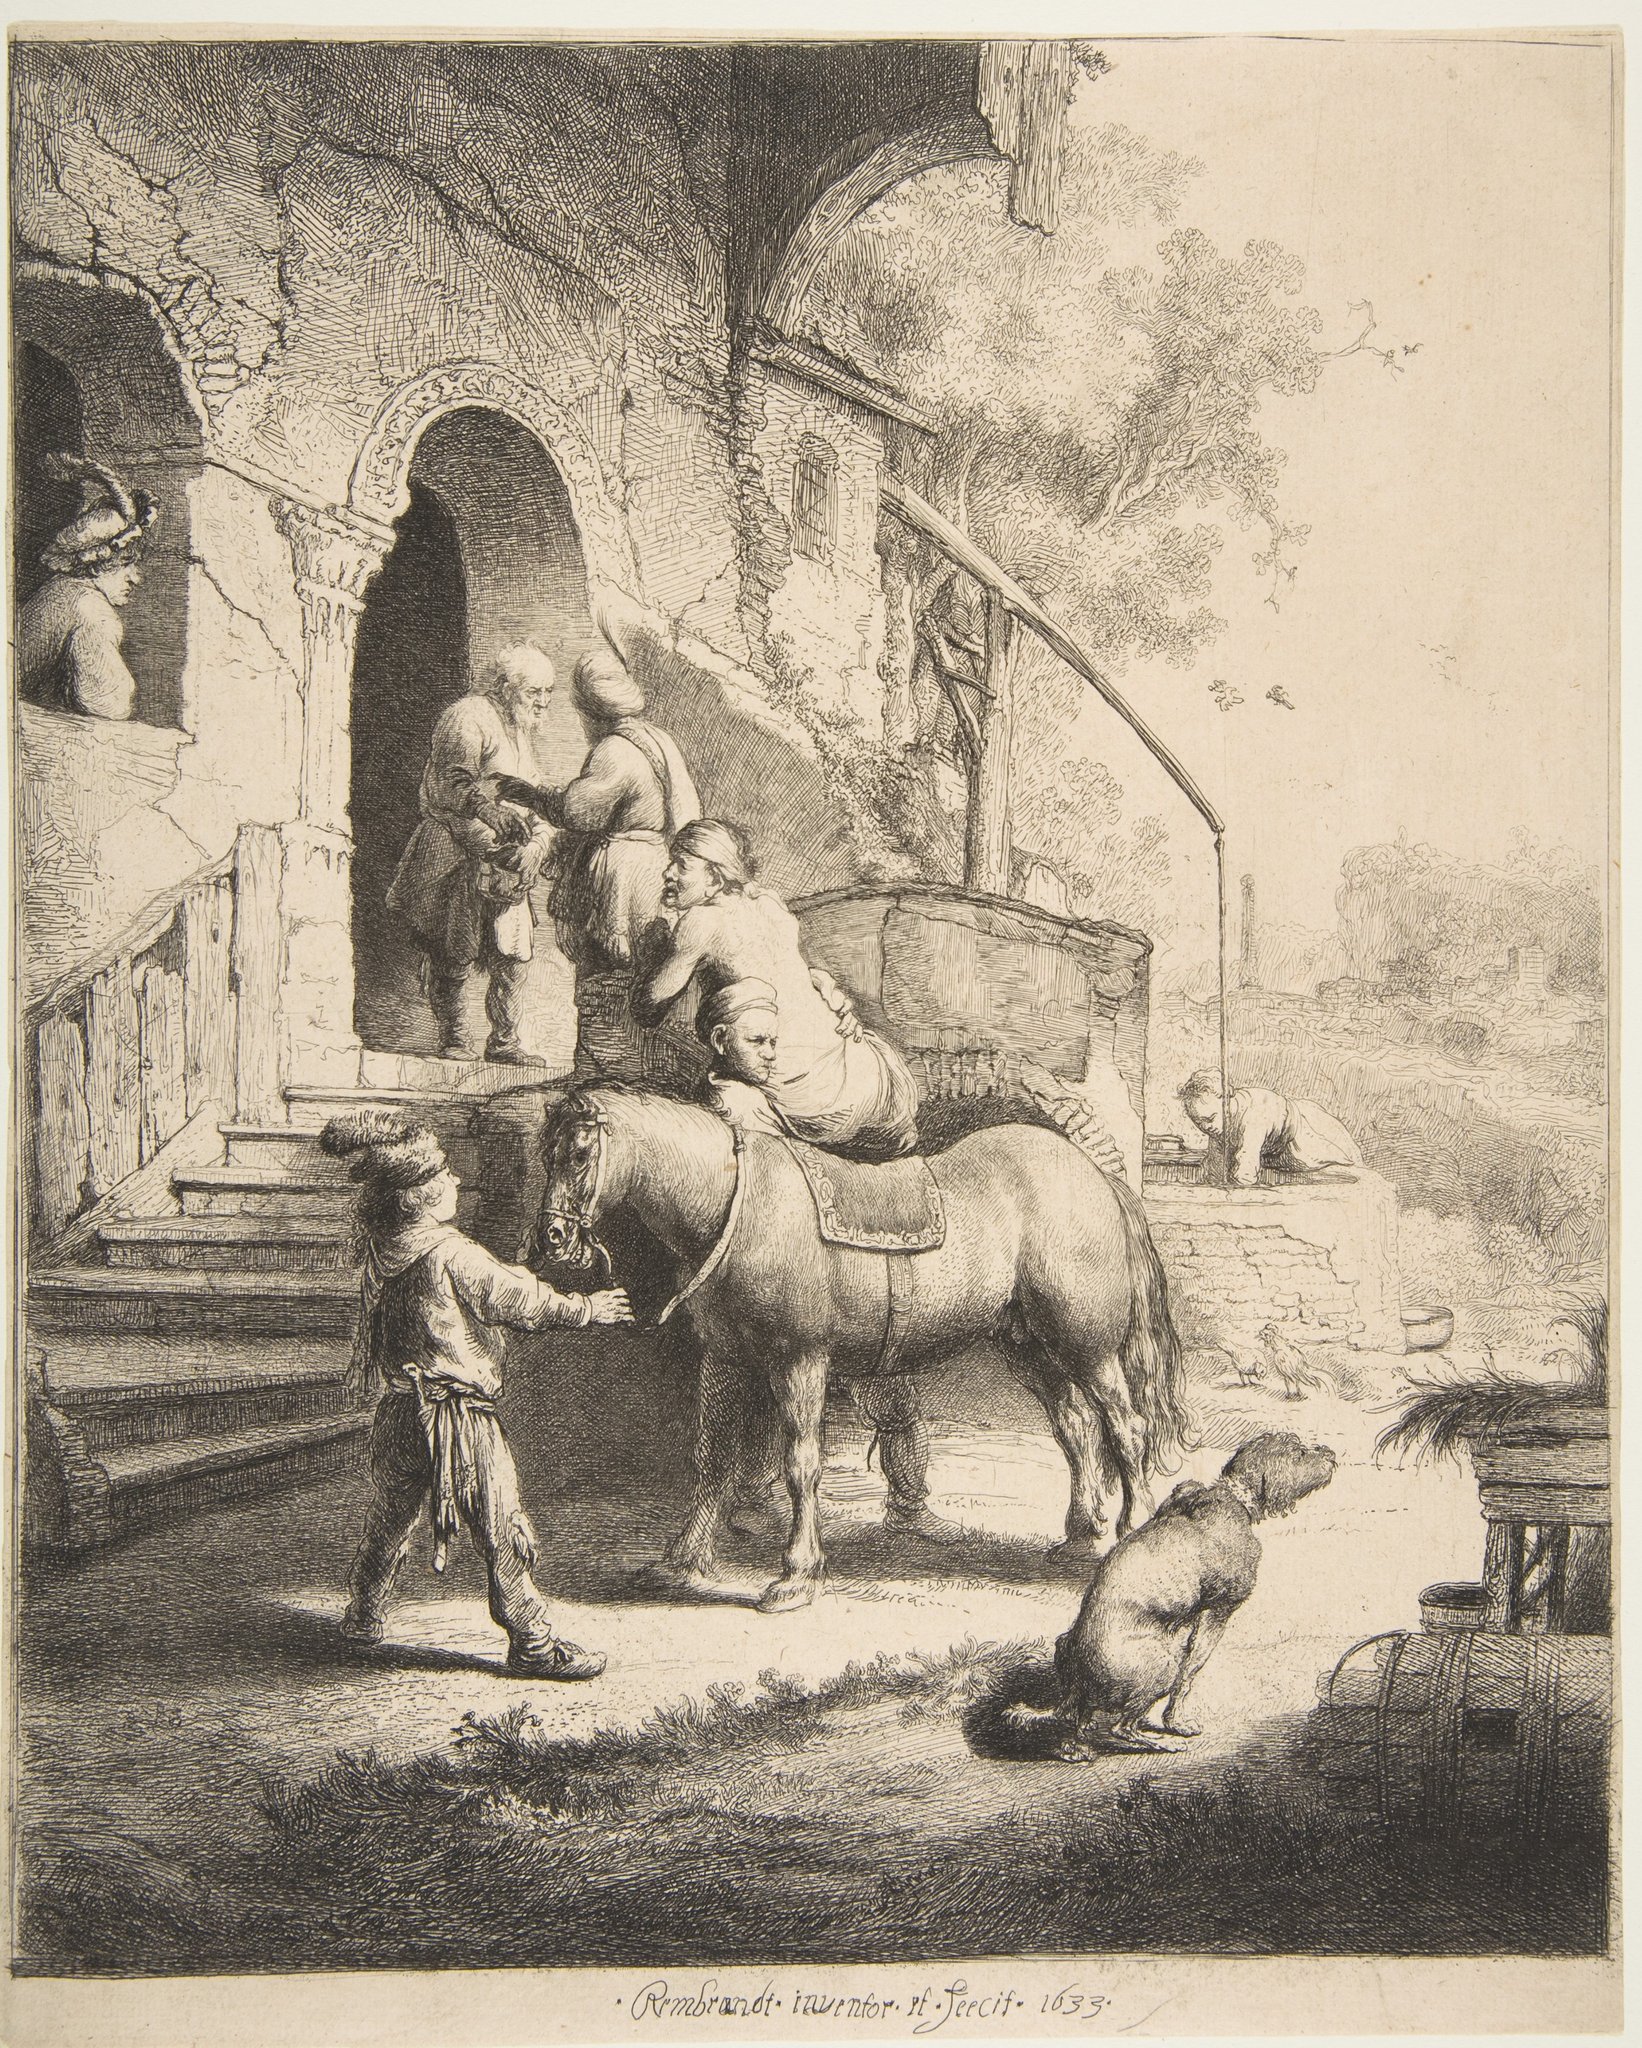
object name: print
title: The Good Samaritan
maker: rembrandt van rijn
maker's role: artist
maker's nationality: dutch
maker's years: 1606-1669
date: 1633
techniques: drypoint, engraving, etching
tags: buildings,stairs,men,dogs,horses,allegory